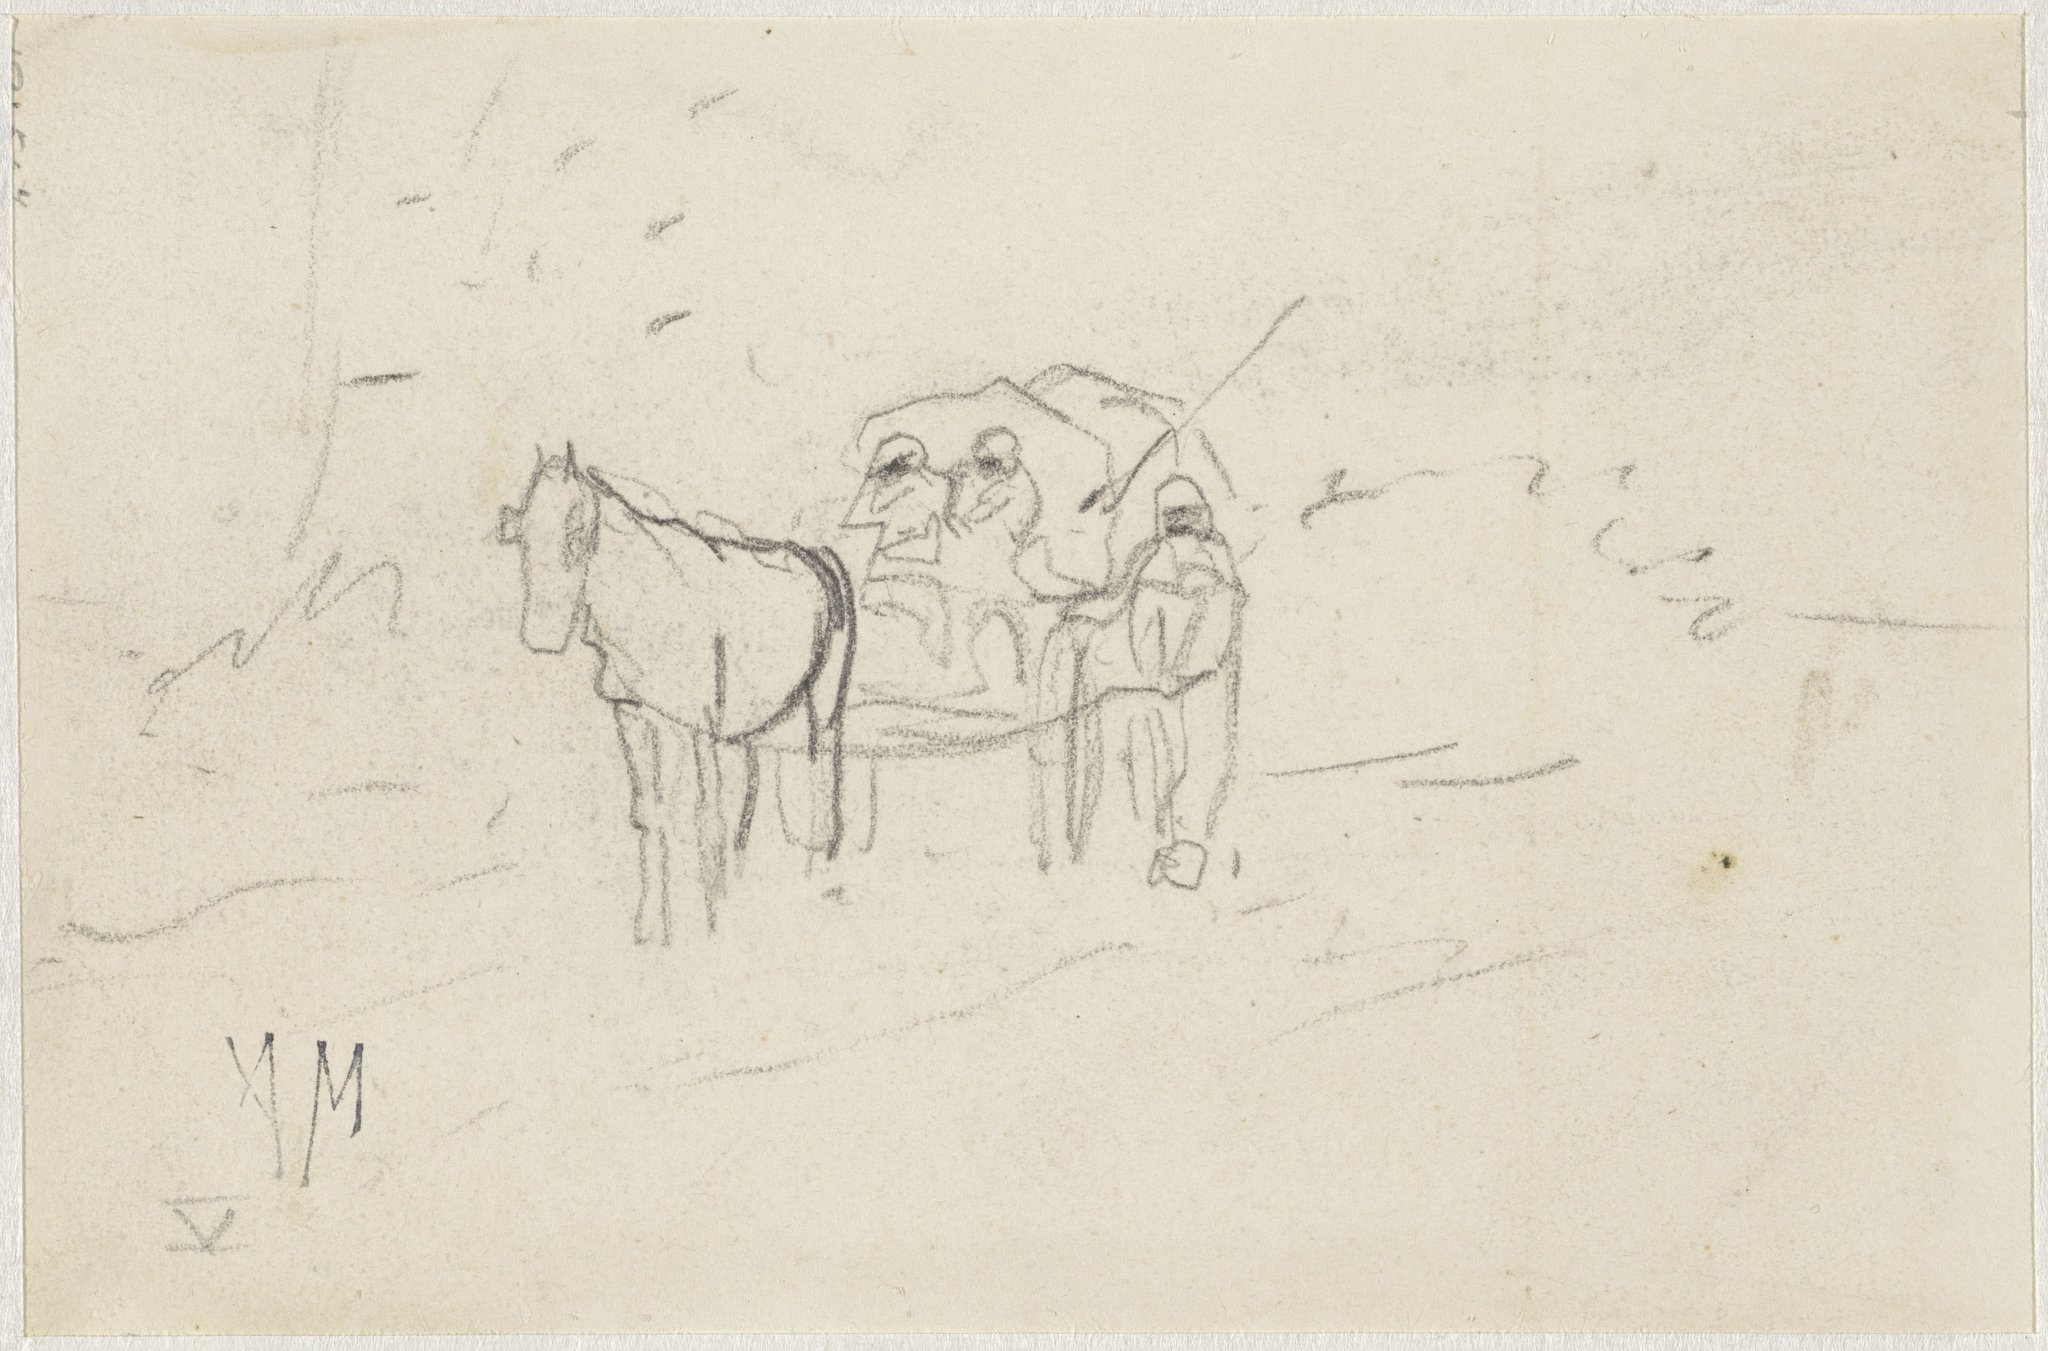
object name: drawing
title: Paard en wagen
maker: anton mauve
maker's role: draughtsman, painter, print maker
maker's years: 1838-1888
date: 1848-1888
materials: chalk, paper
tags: (farm) wagon, freight wagon, cart